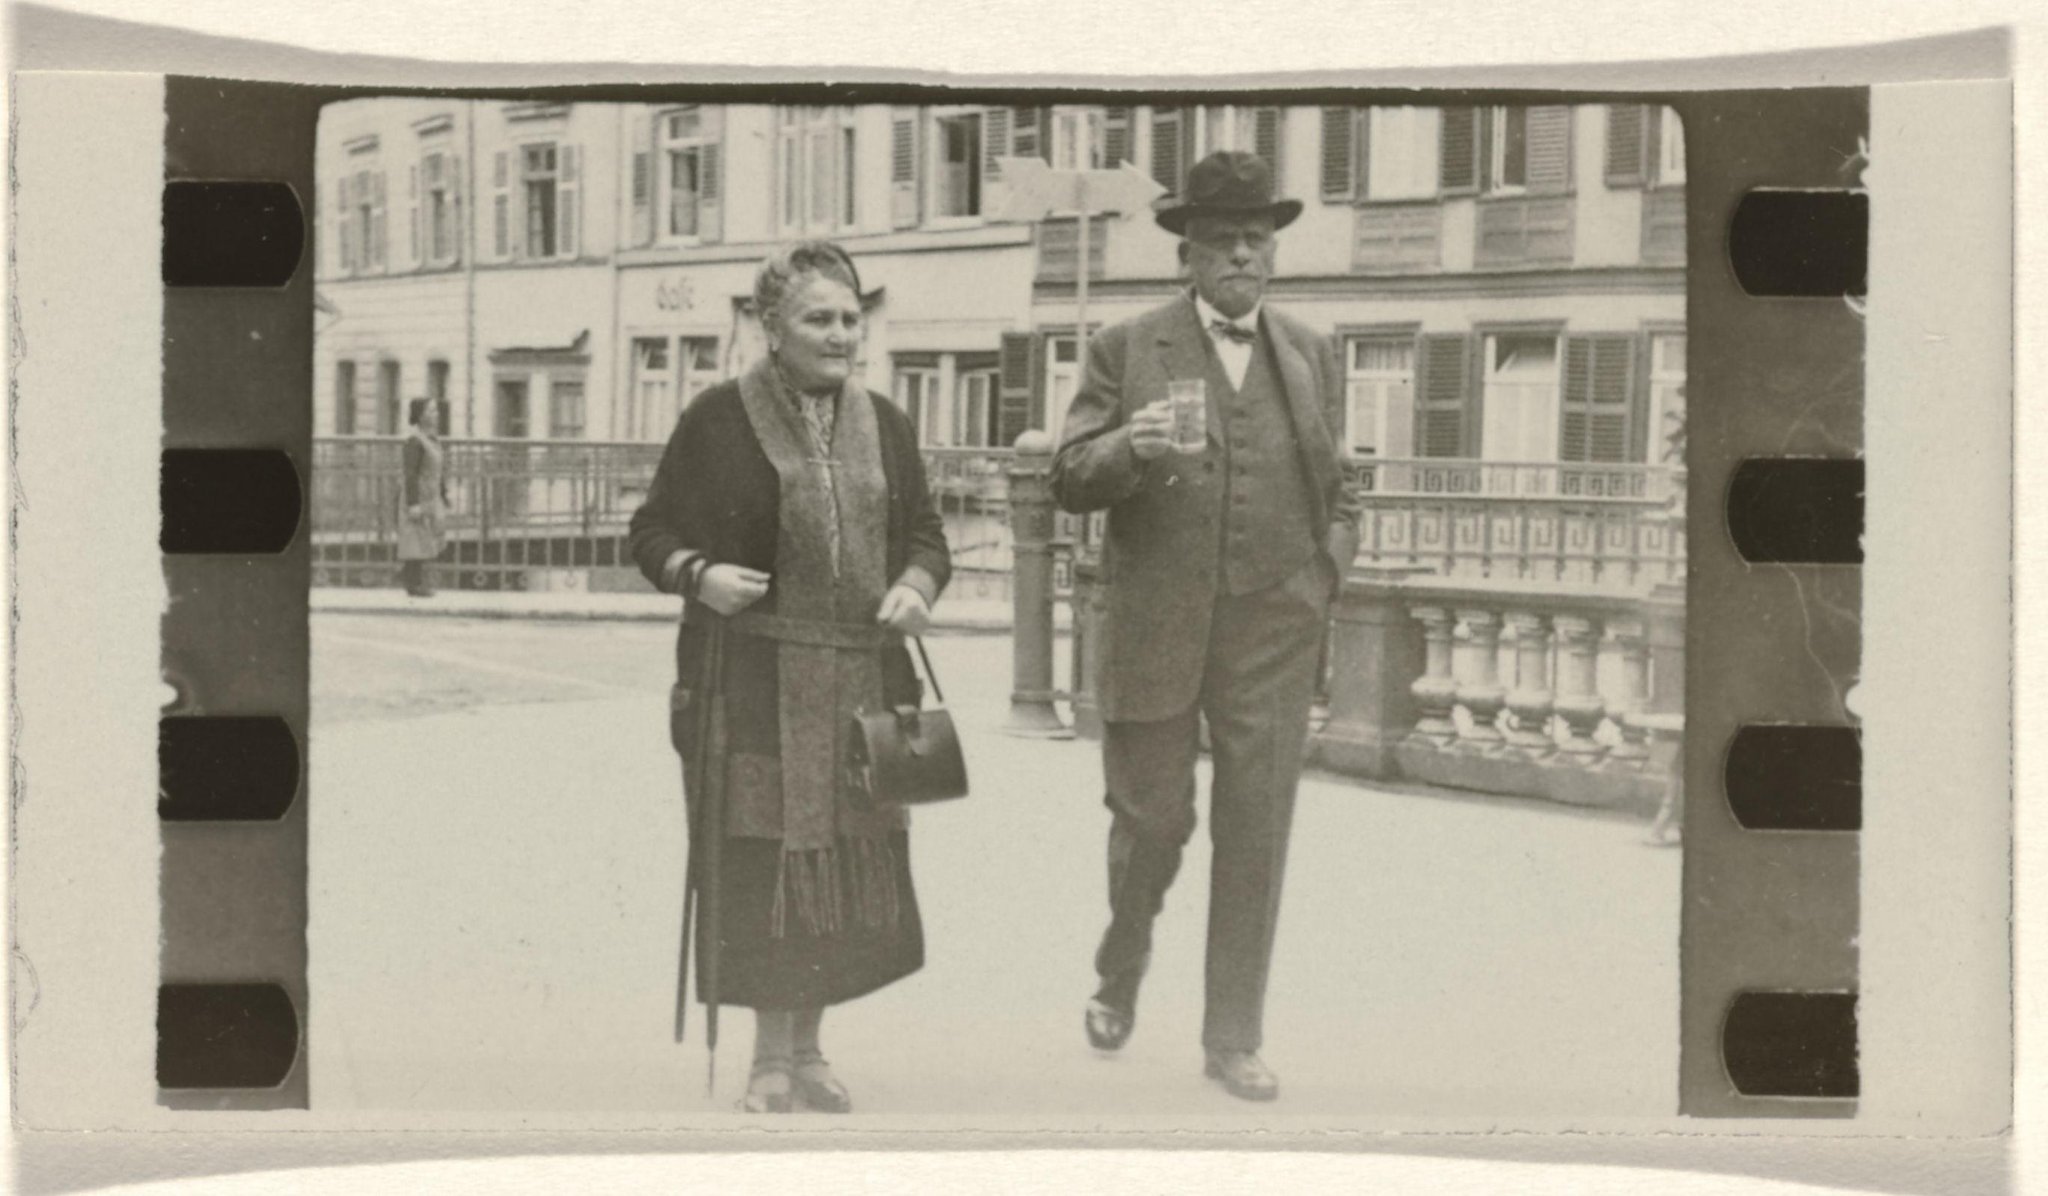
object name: photograph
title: Meir Wachenheimer met een glas in zijn handen en zijn echtgenote Mathilde Wachenheimer-Wertheimer met een paraplu om haar arm en een tas in haar hand, lopend over straat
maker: Anonymous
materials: photographic support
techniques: gelatin silver print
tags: meir wachenheimer, sobibór, mathilde wachenheimer-wertheimer